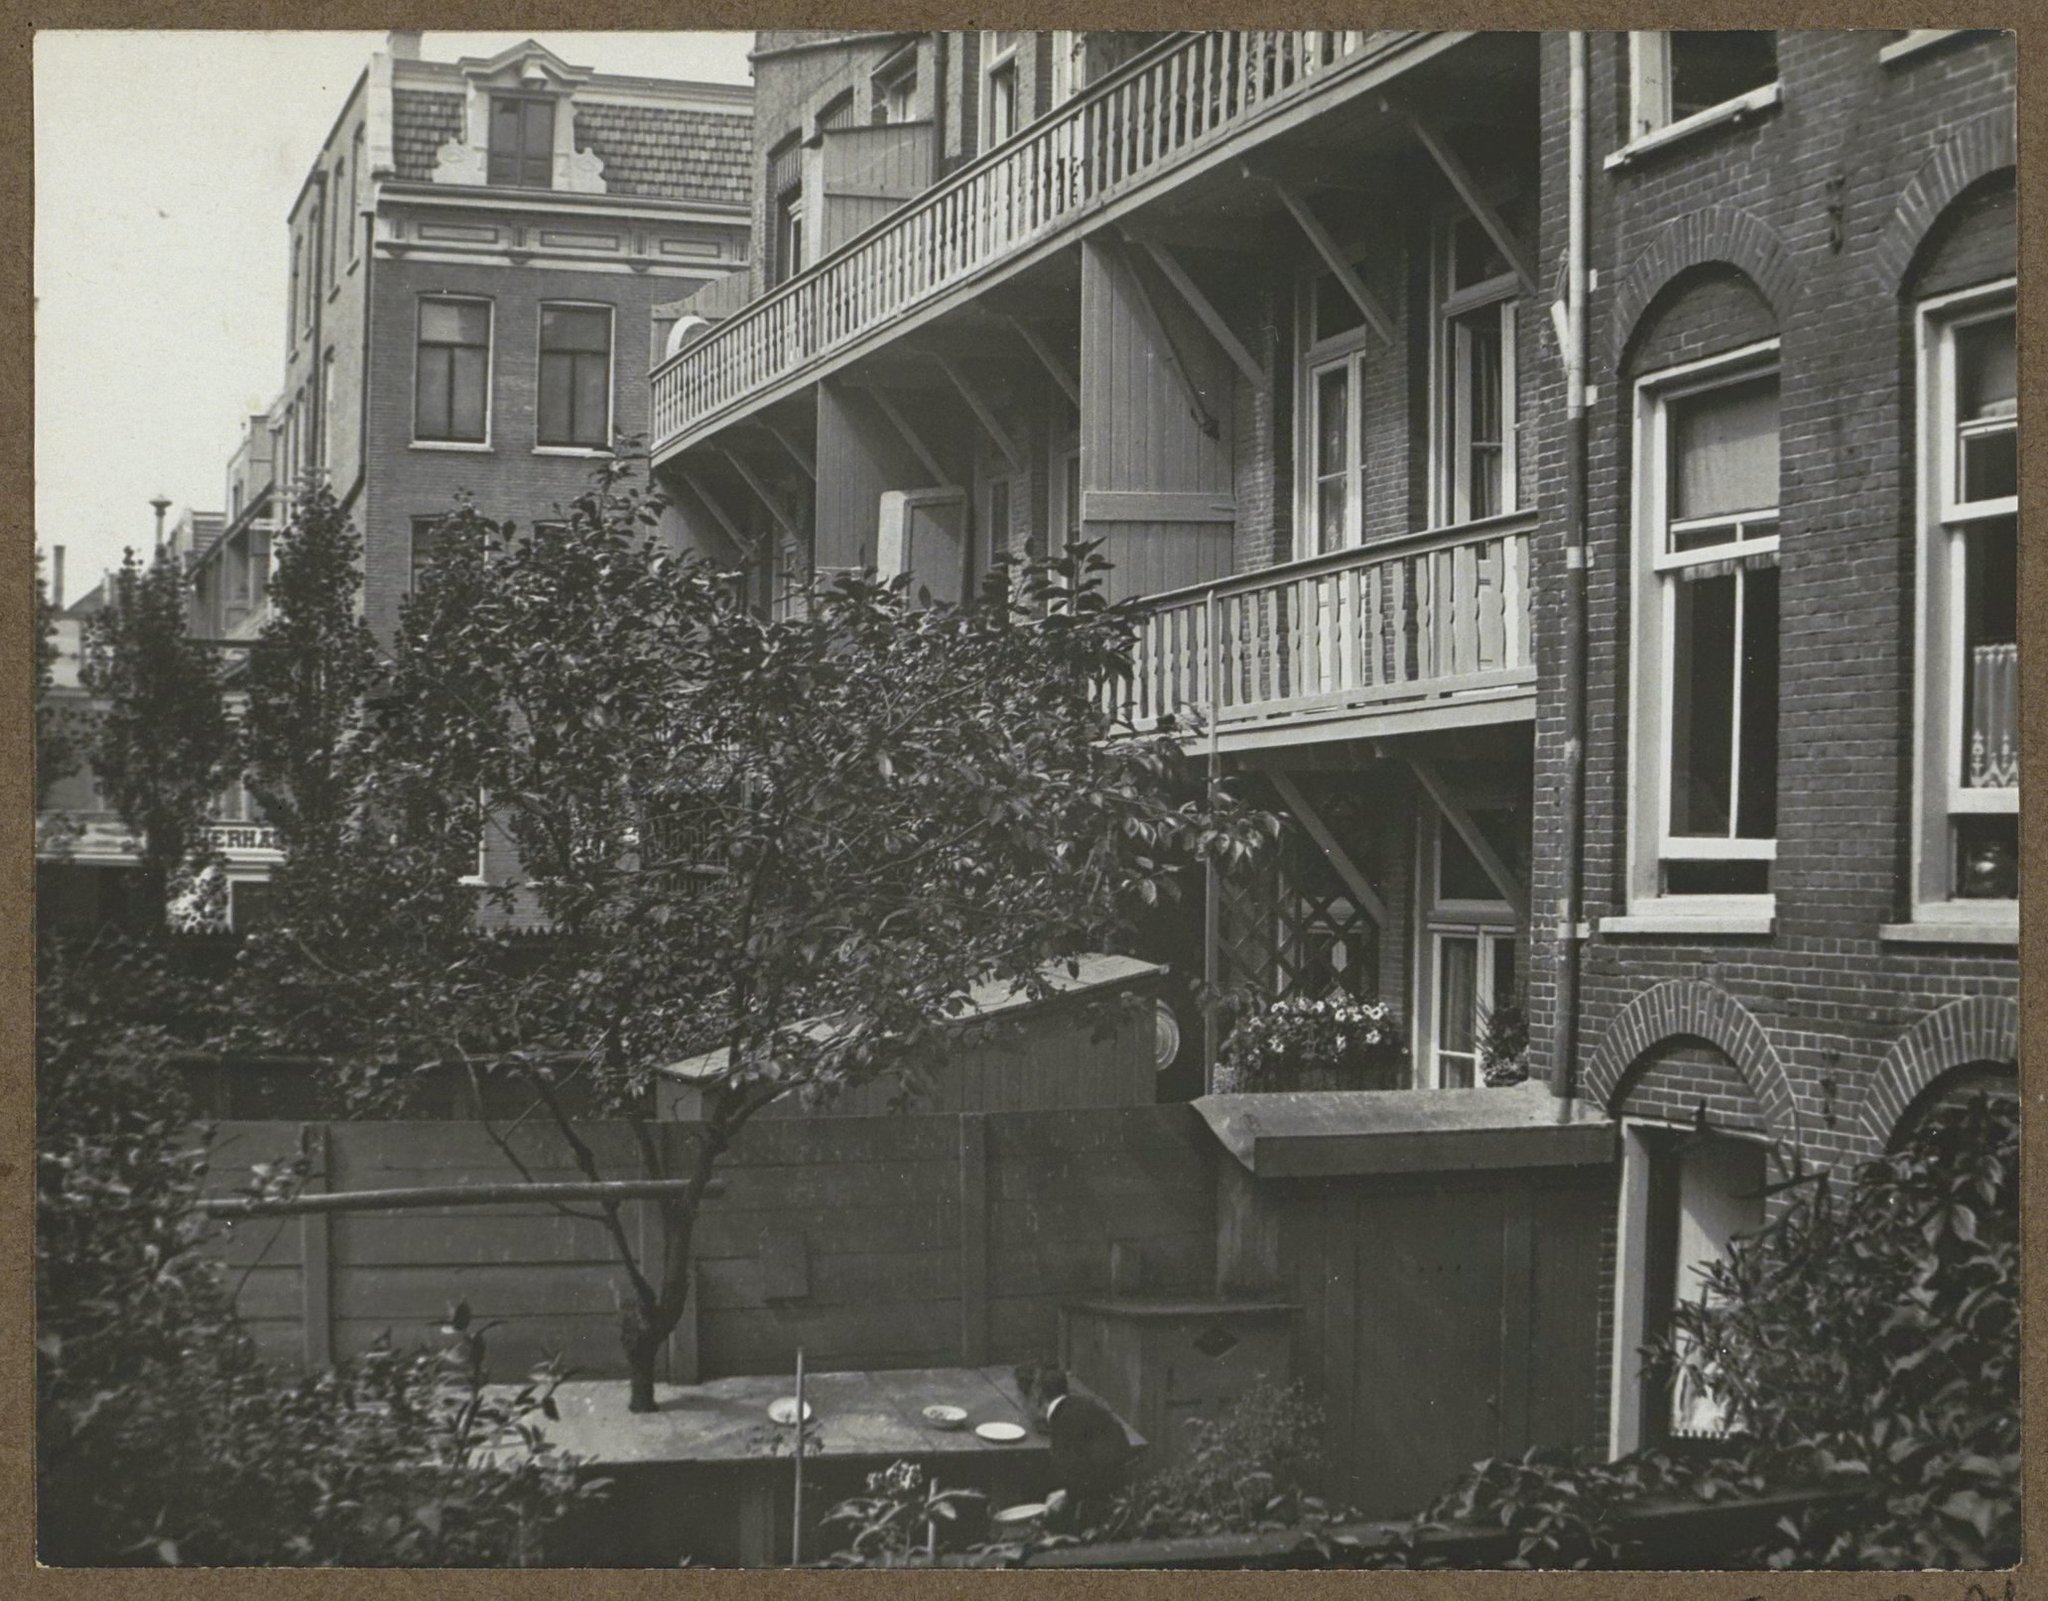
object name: photograph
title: Tuin en achtergevel van Eerste Helmersstraat 110 te Amsterdam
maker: Anonymous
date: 1910-1930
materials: paper, photographic support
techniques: gelatin silver print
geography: amsterdam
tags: façade (of house or building)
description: Onderdeel van Album met foto's van Amsterdam en omgeving.